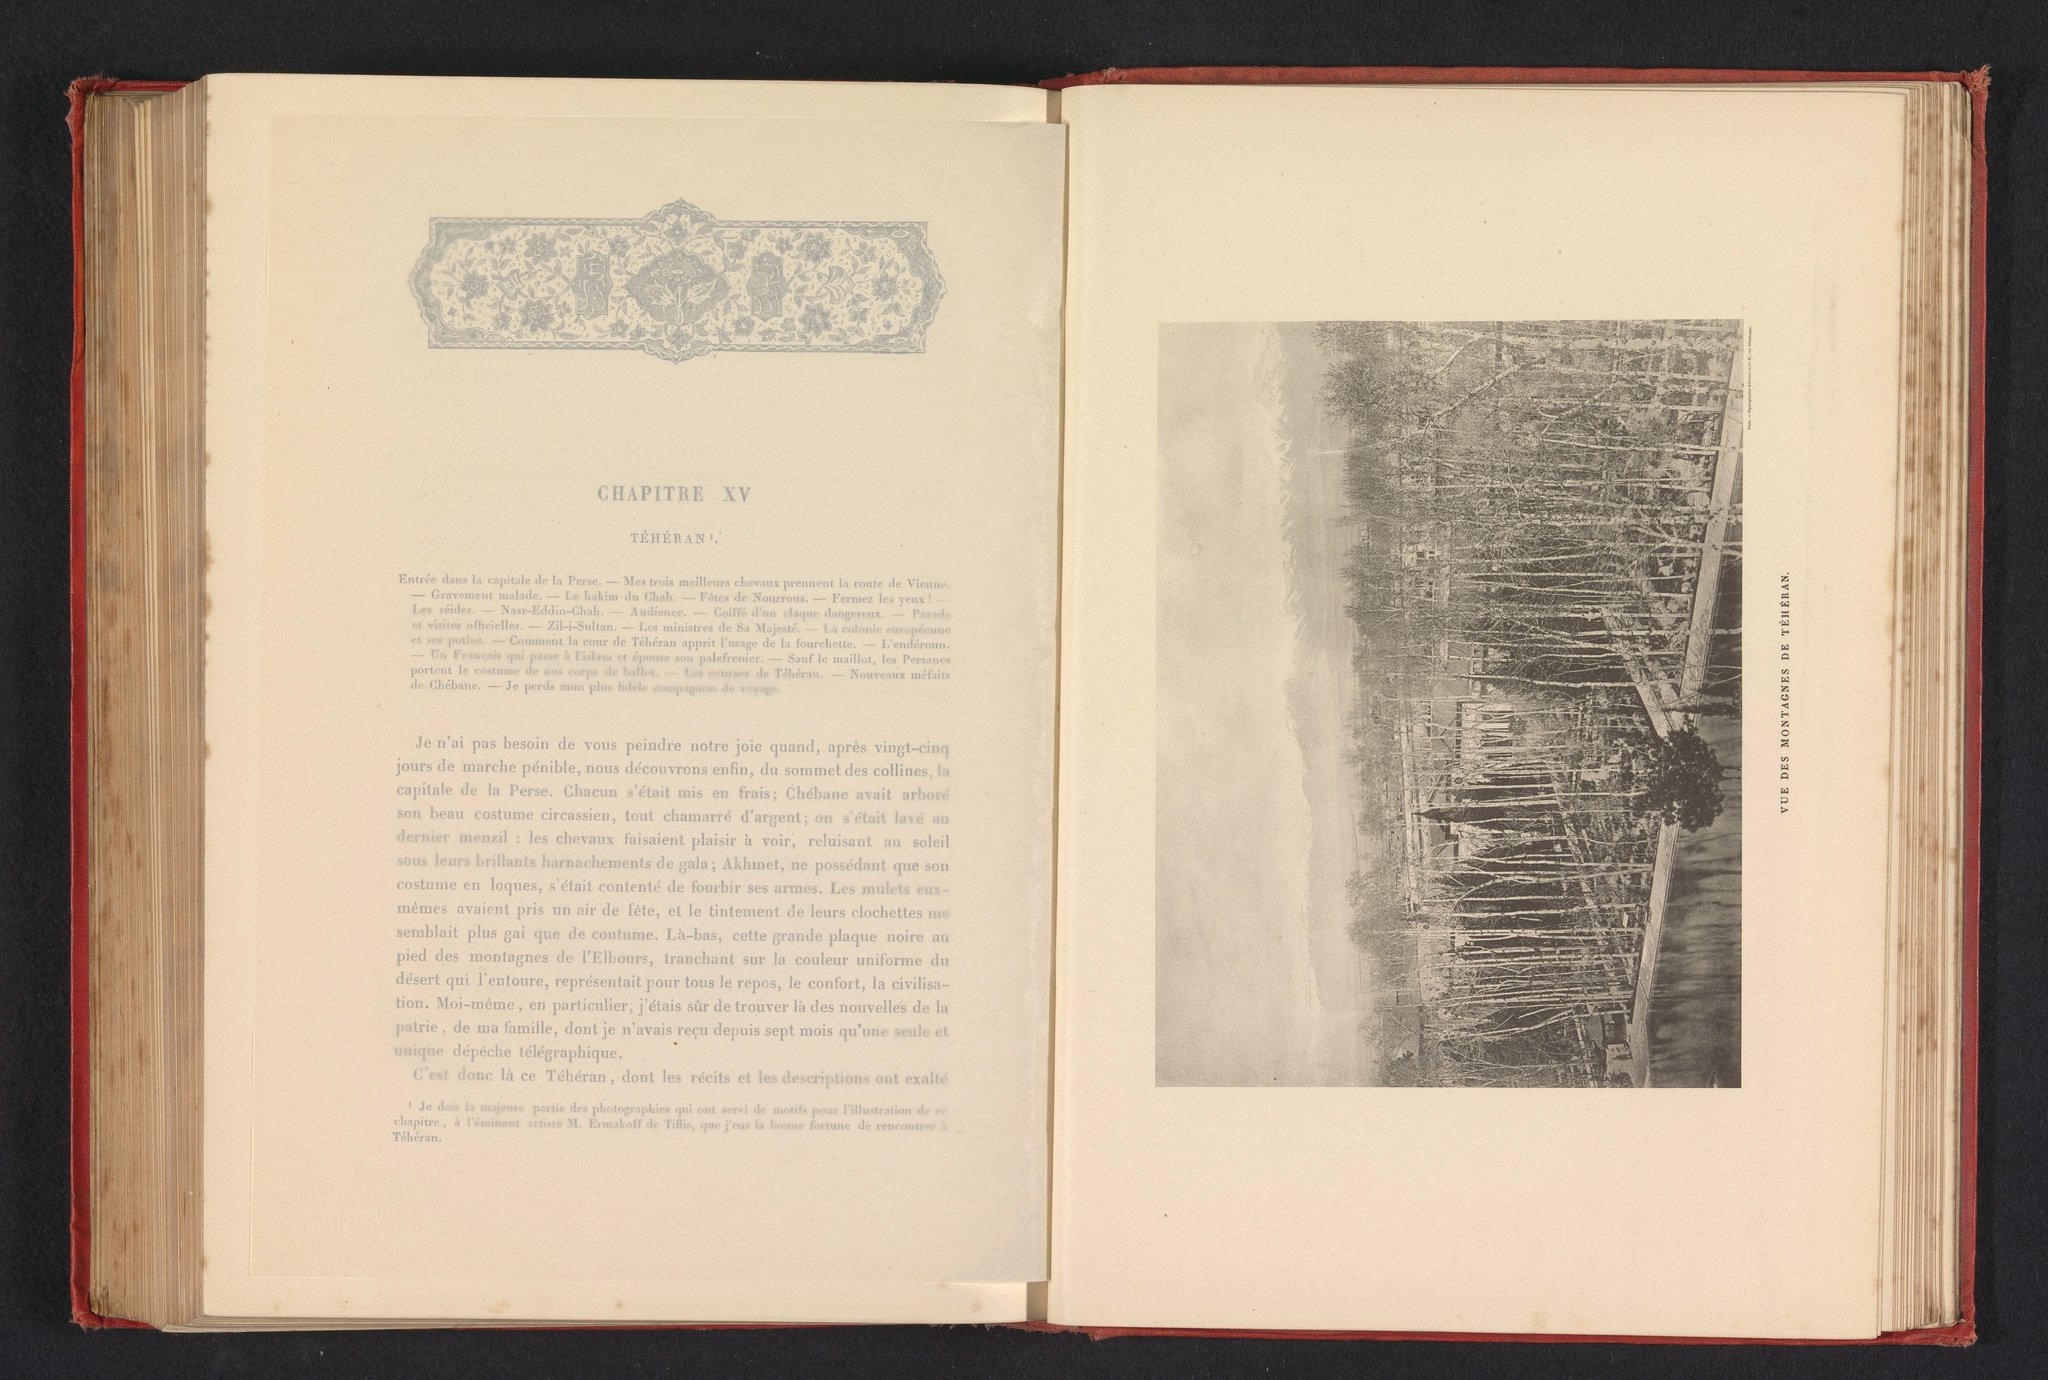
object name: photomechanical print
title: Gezicht op bergen in Teheran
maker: Anonymous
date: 1869-1885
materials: paper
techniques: photograph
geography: paris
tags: mountains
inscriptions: name: ‘Silvestre et Cie, 97, rue Oberkampf.’